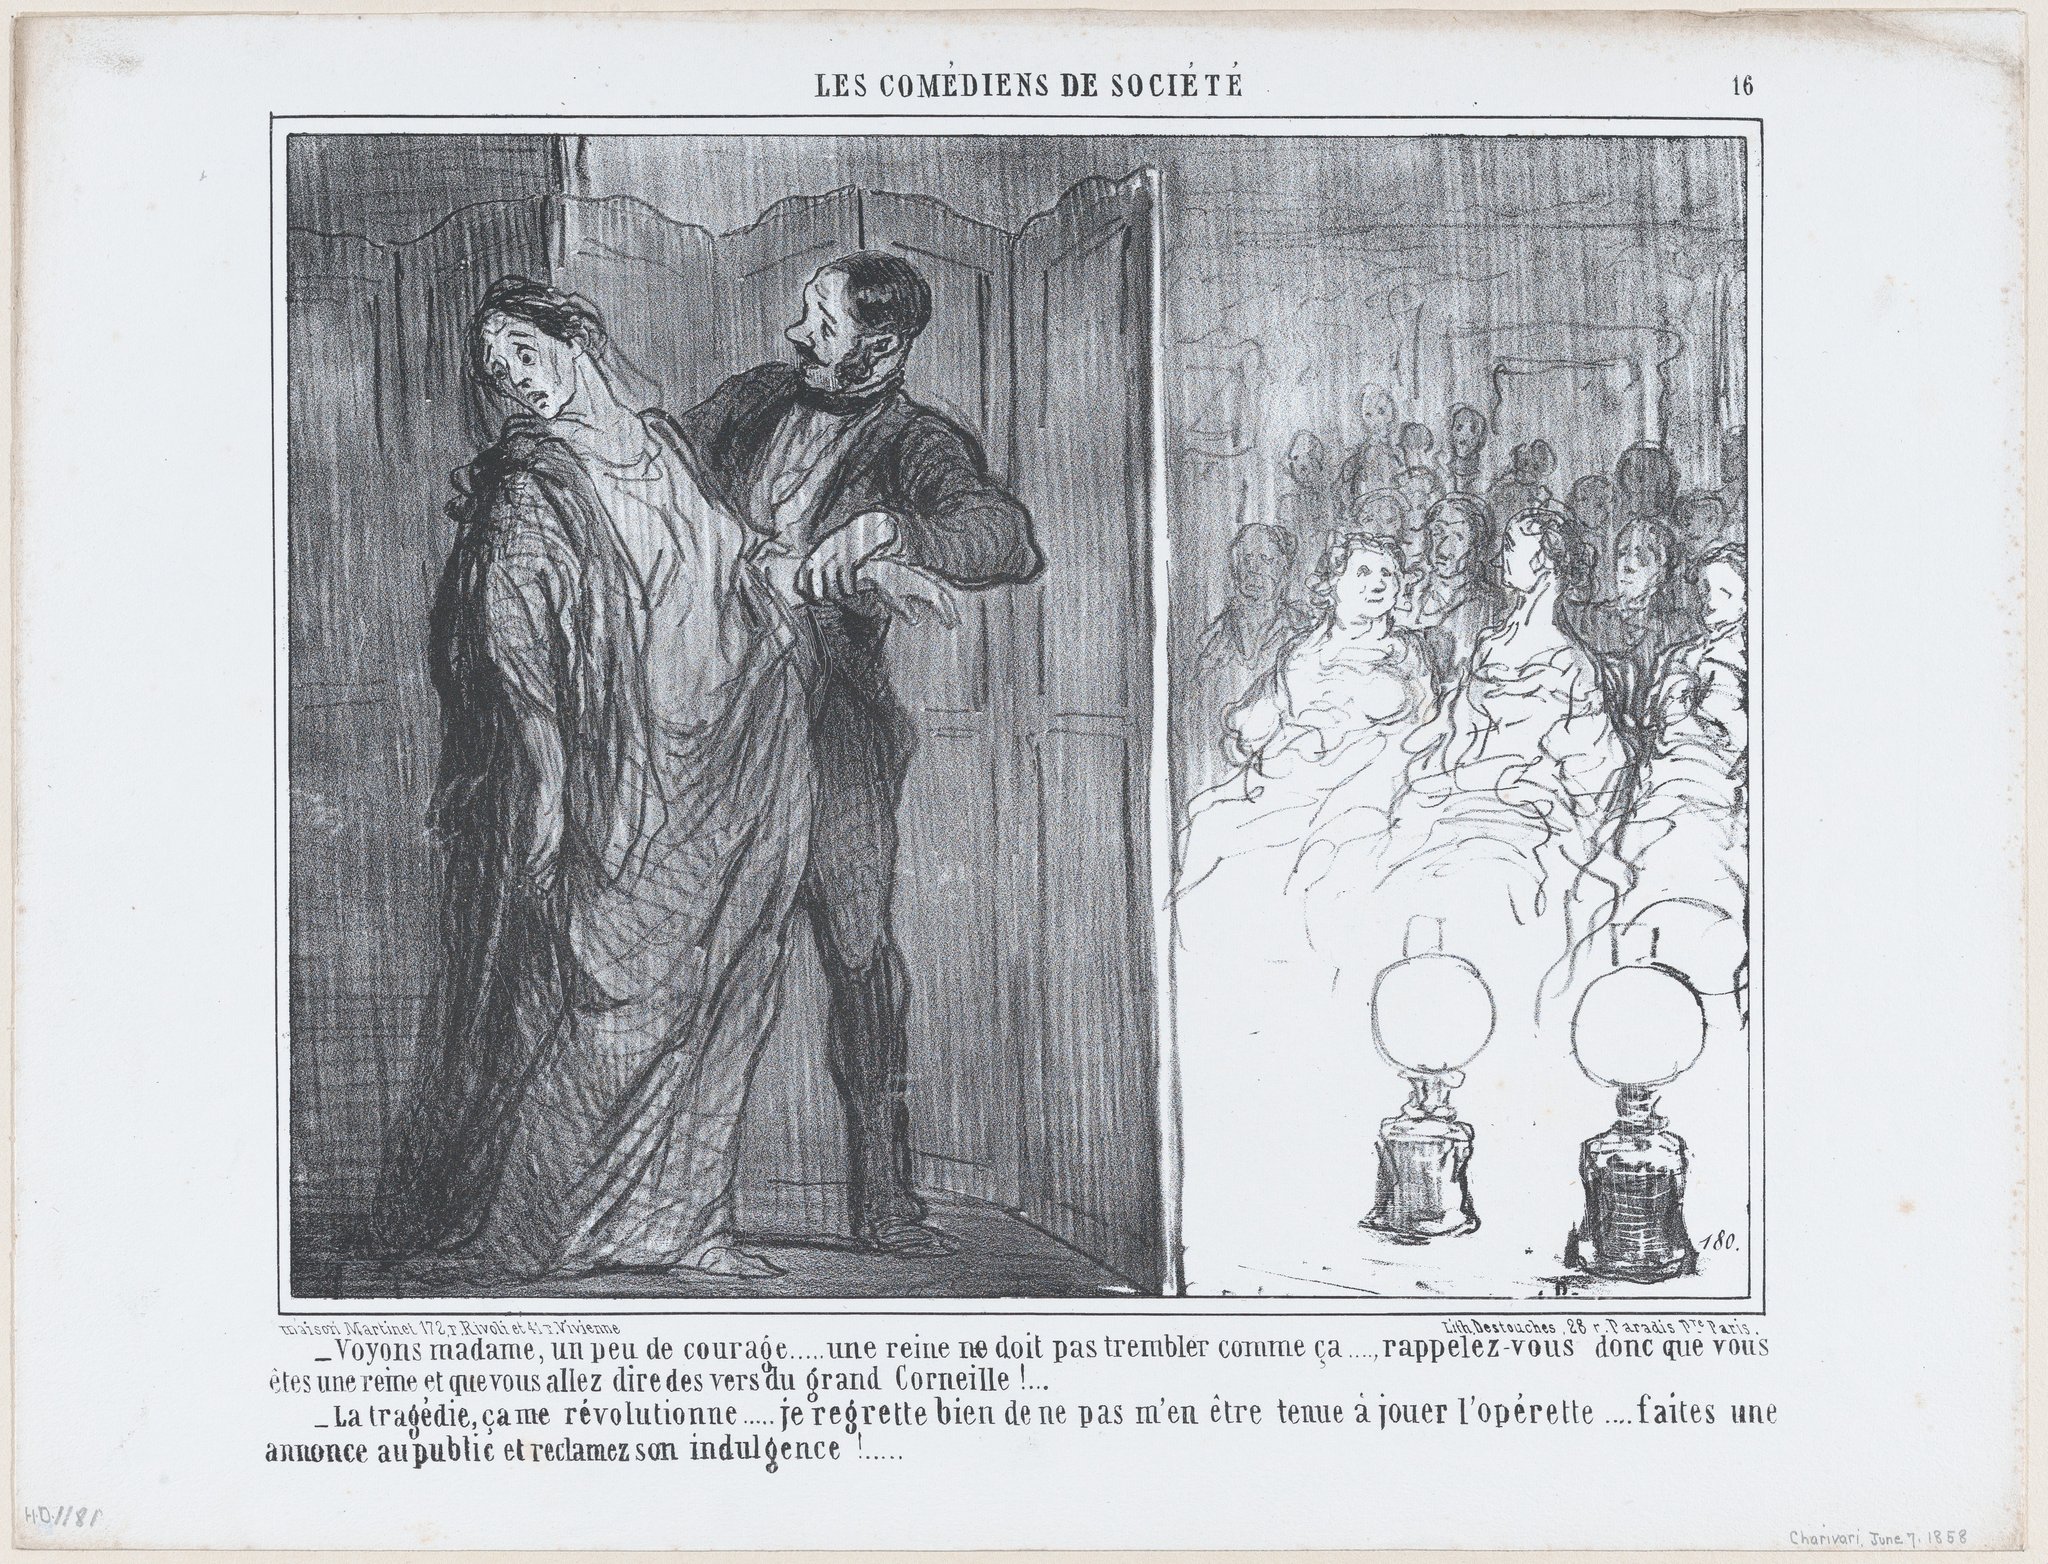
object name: print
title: Voyons madame, un peu de courage..., from Les Comédiens de Société, published in "Le Charivari"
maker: honoré daumier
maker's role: artist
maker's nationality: french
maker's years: 1808-1879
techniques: lithograph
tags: men,women